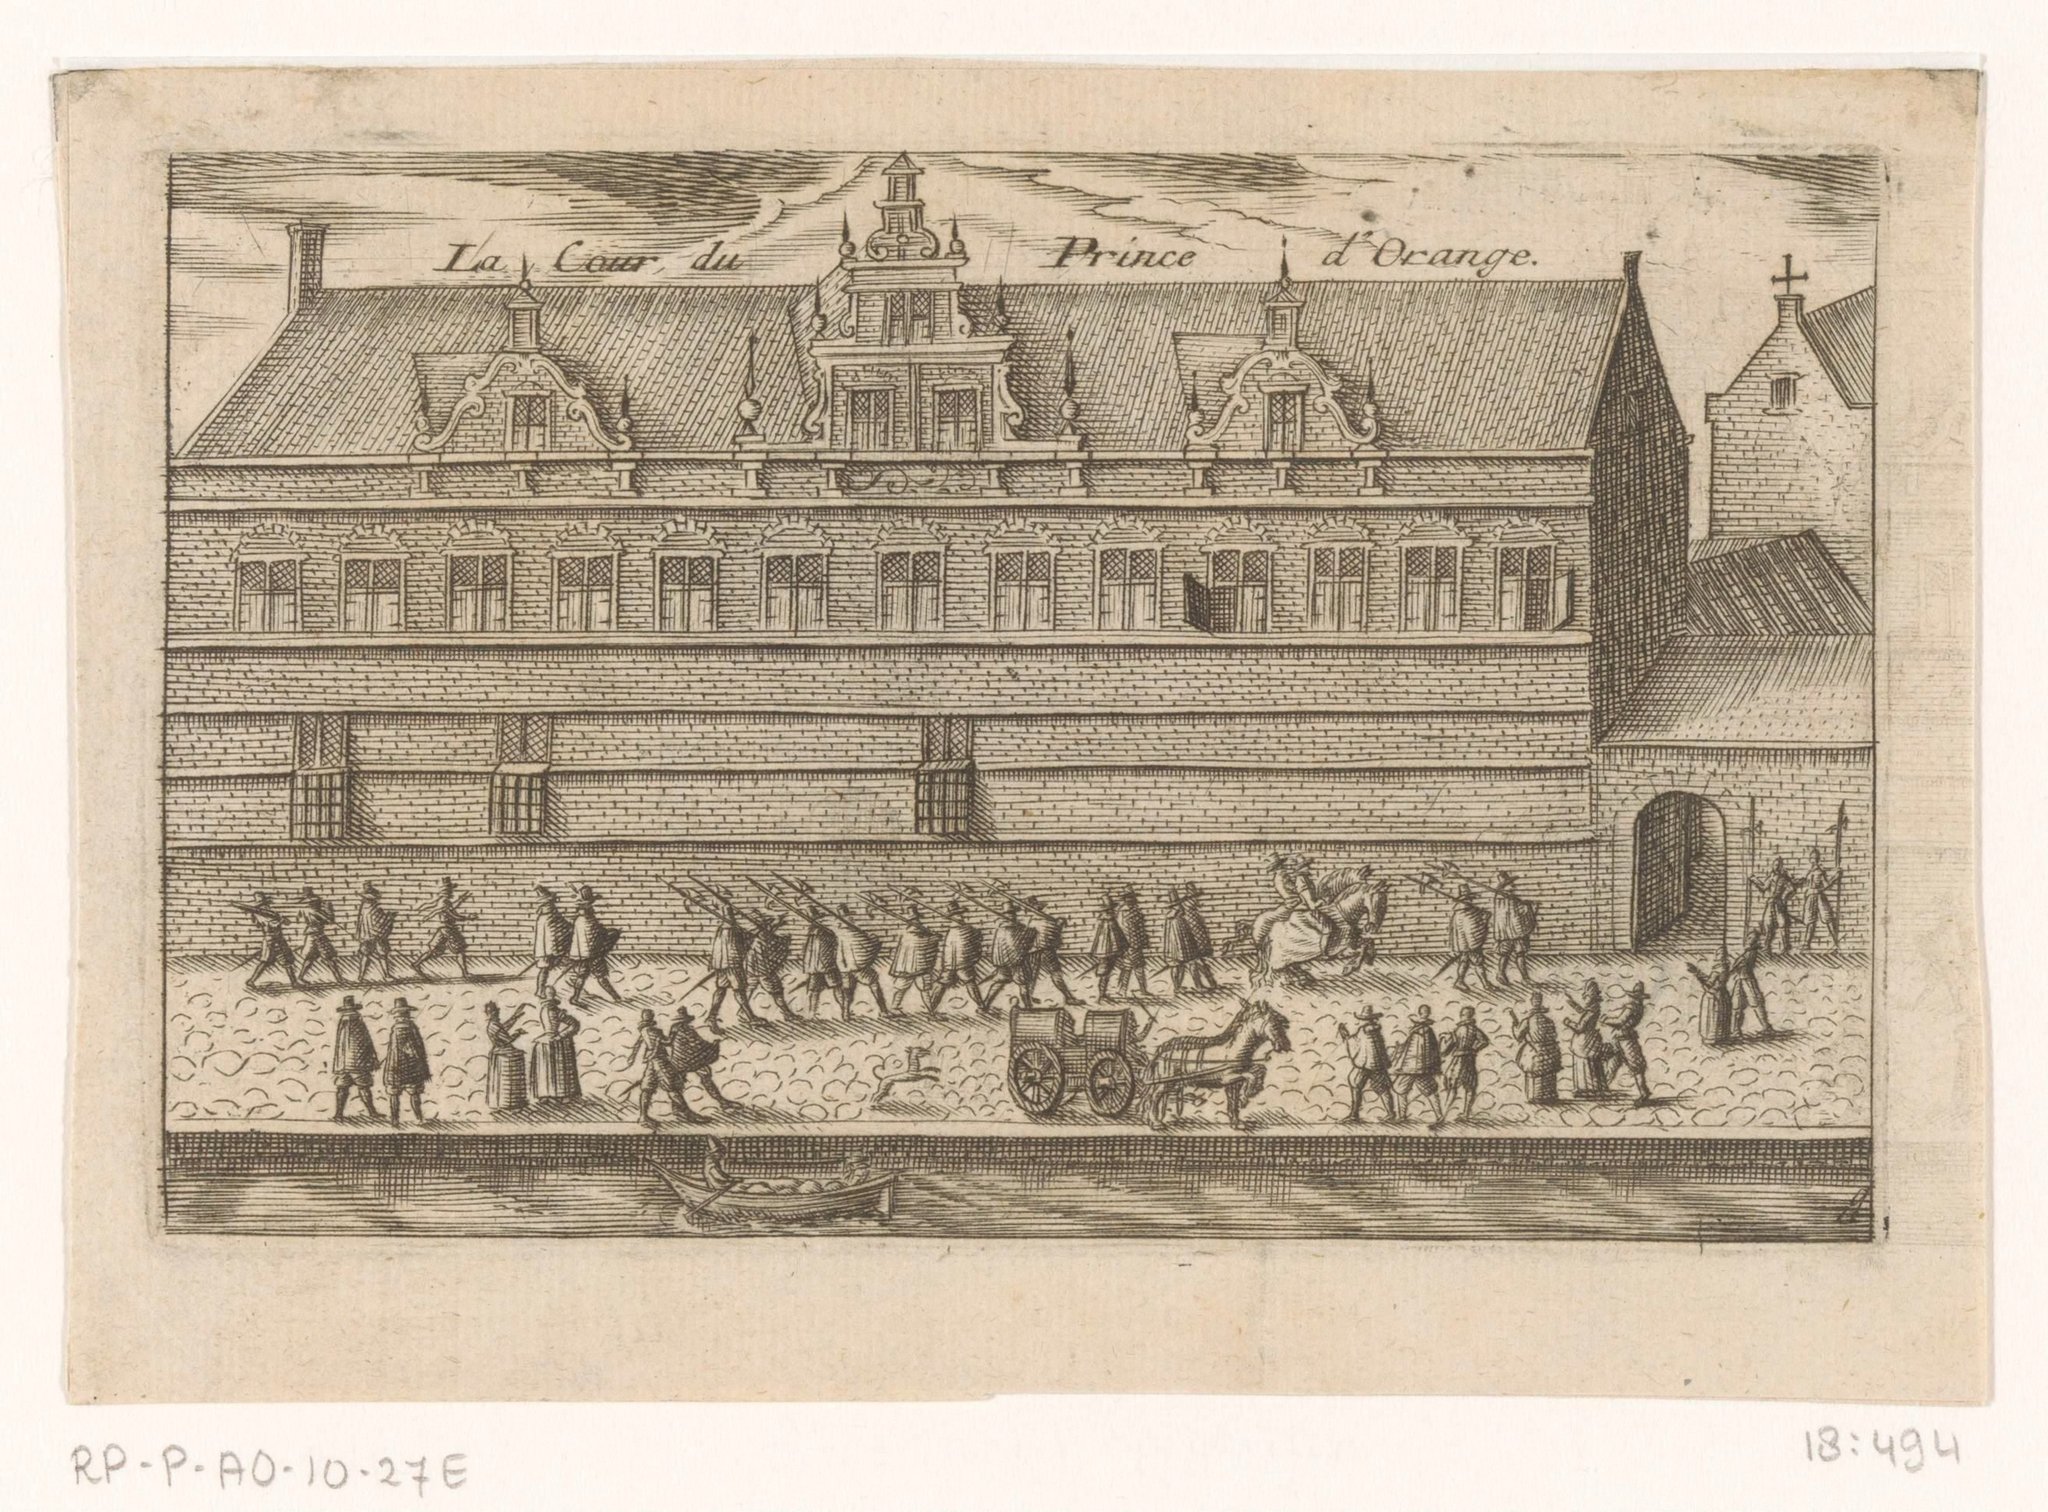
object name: print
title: La Cour du Prince d'Orange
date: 1712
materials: paper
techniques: engraving, etching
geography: leiden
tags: exterior ~ representation of a building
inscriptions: collector's mark: Lugt 2228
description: Prent ook gebruikt in: Les delices de Leide, une des célébres villes de l'Europe, qui contiennent une description exacte de son antiquité, de ses divers aggrandissemens, de son académie, de ses manufactures, de ses curiosités (...). Leiden: Pieter van der Aa, 1712.